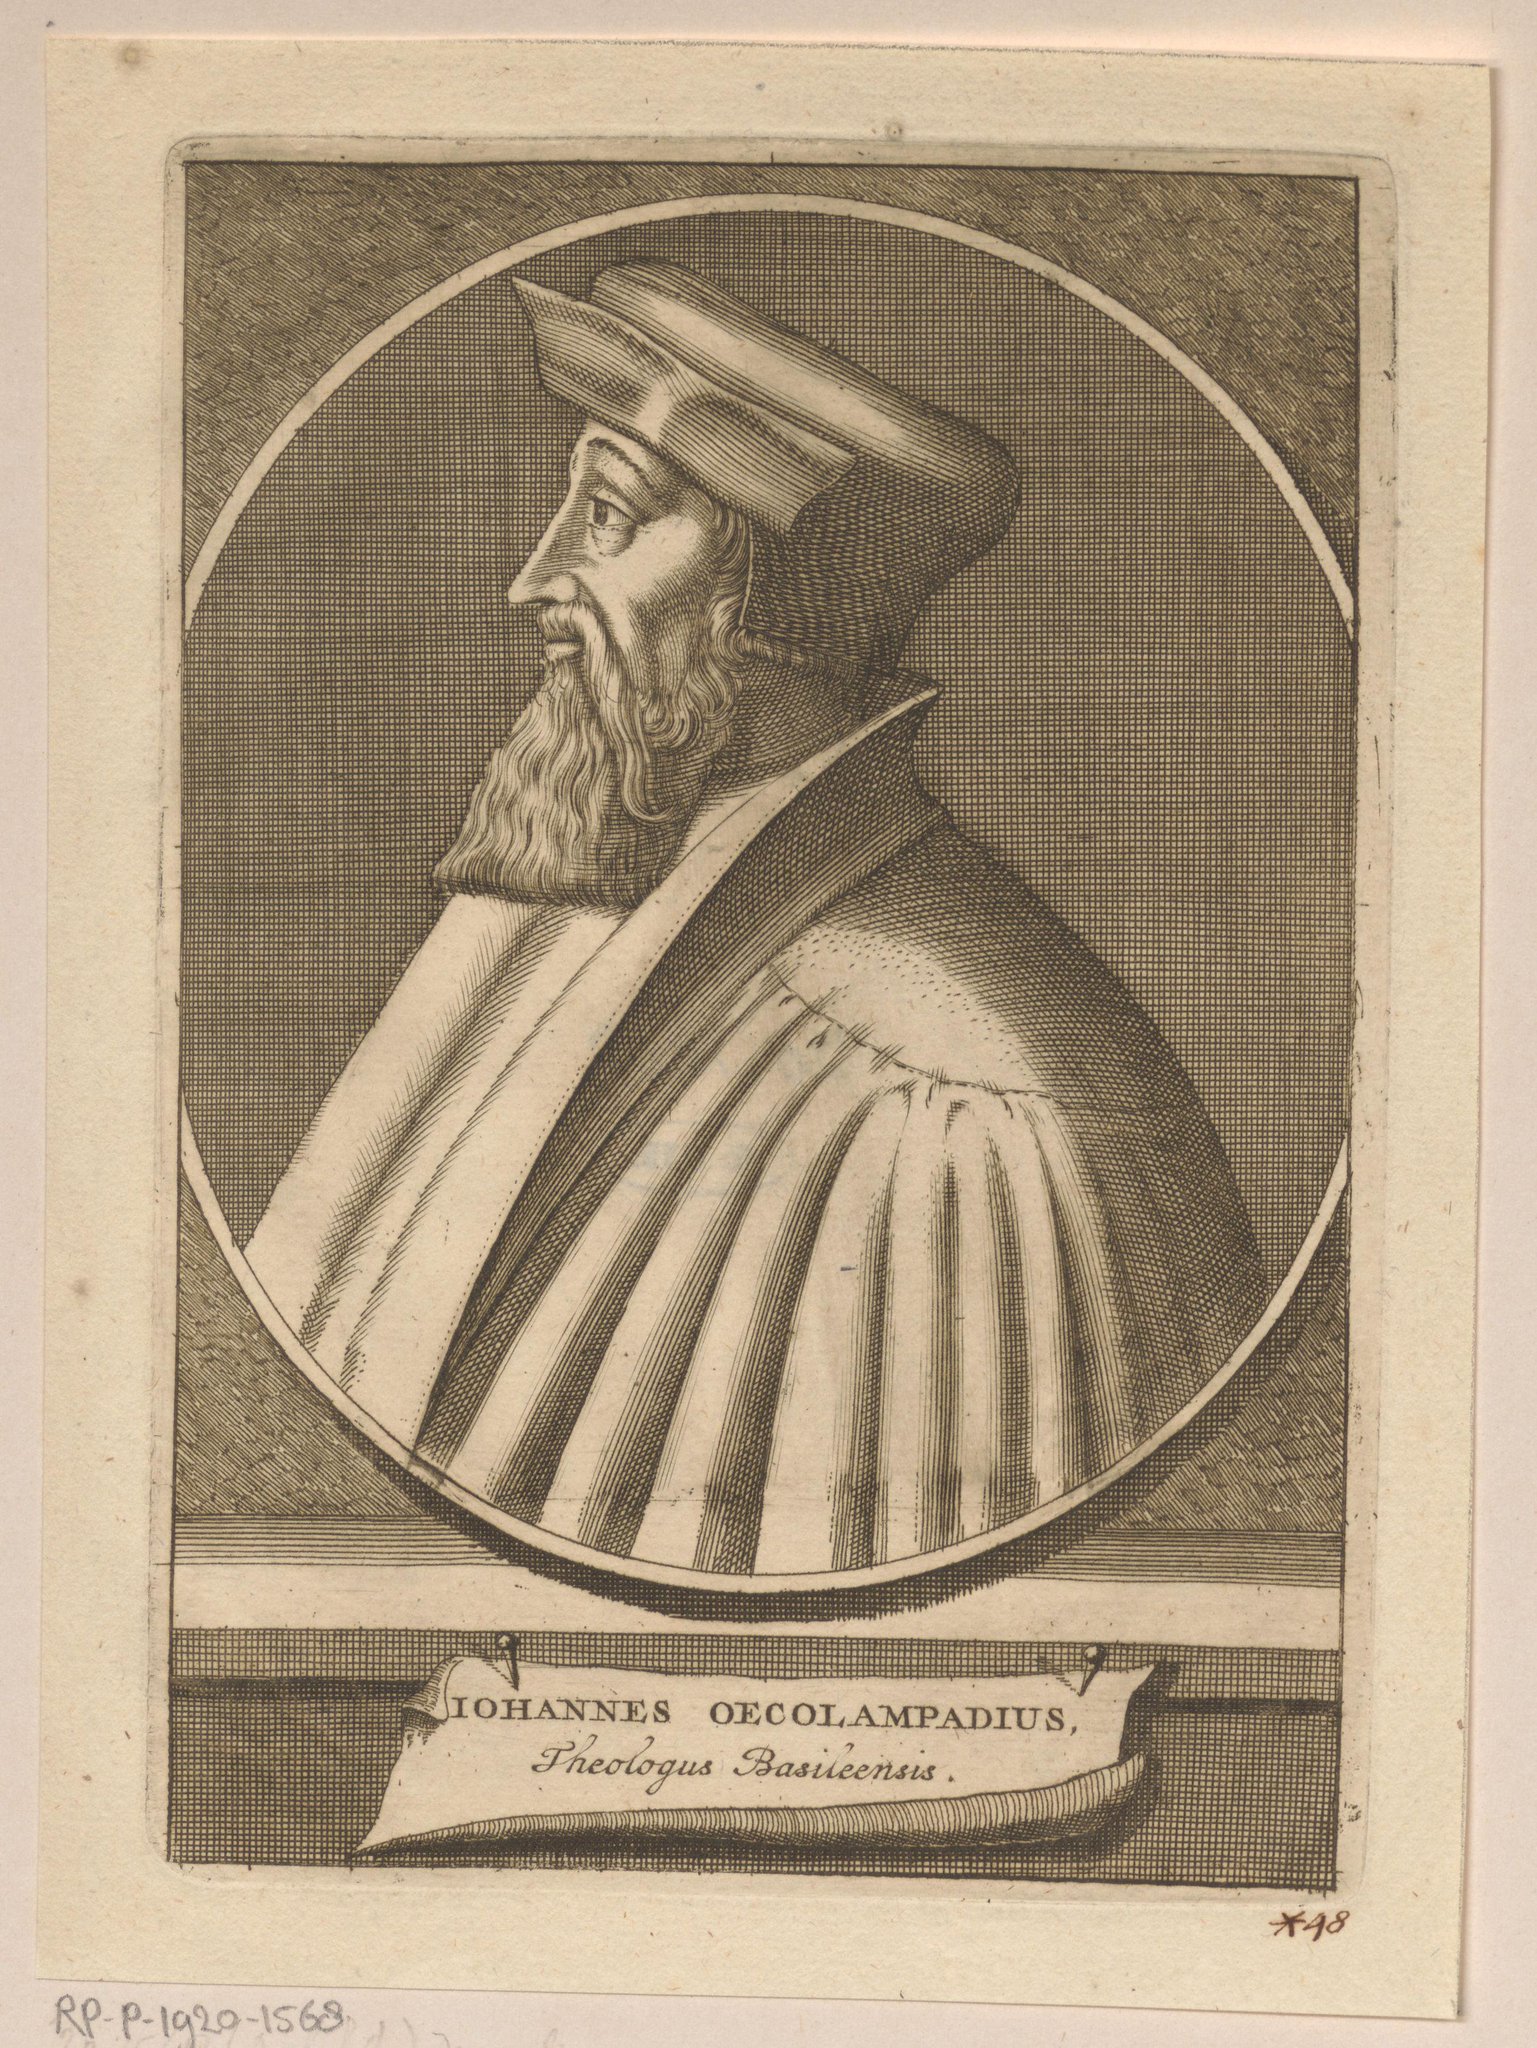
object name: print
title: Portret van Johannes Oecolampadius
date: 1690-1729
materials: paper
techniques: engraving, etching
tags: theologian, historical persons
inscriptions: collector's mark: Lugt 2228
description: Prent mogelijk uit: Le miroir des portraits des premiers reformateurs des églises protestantes. Leiden: Pieter van der Aa, [1690-1729]. Eerdere staat gebruikt in serie uit 1599 en publicaties uit 1602 en 1604.